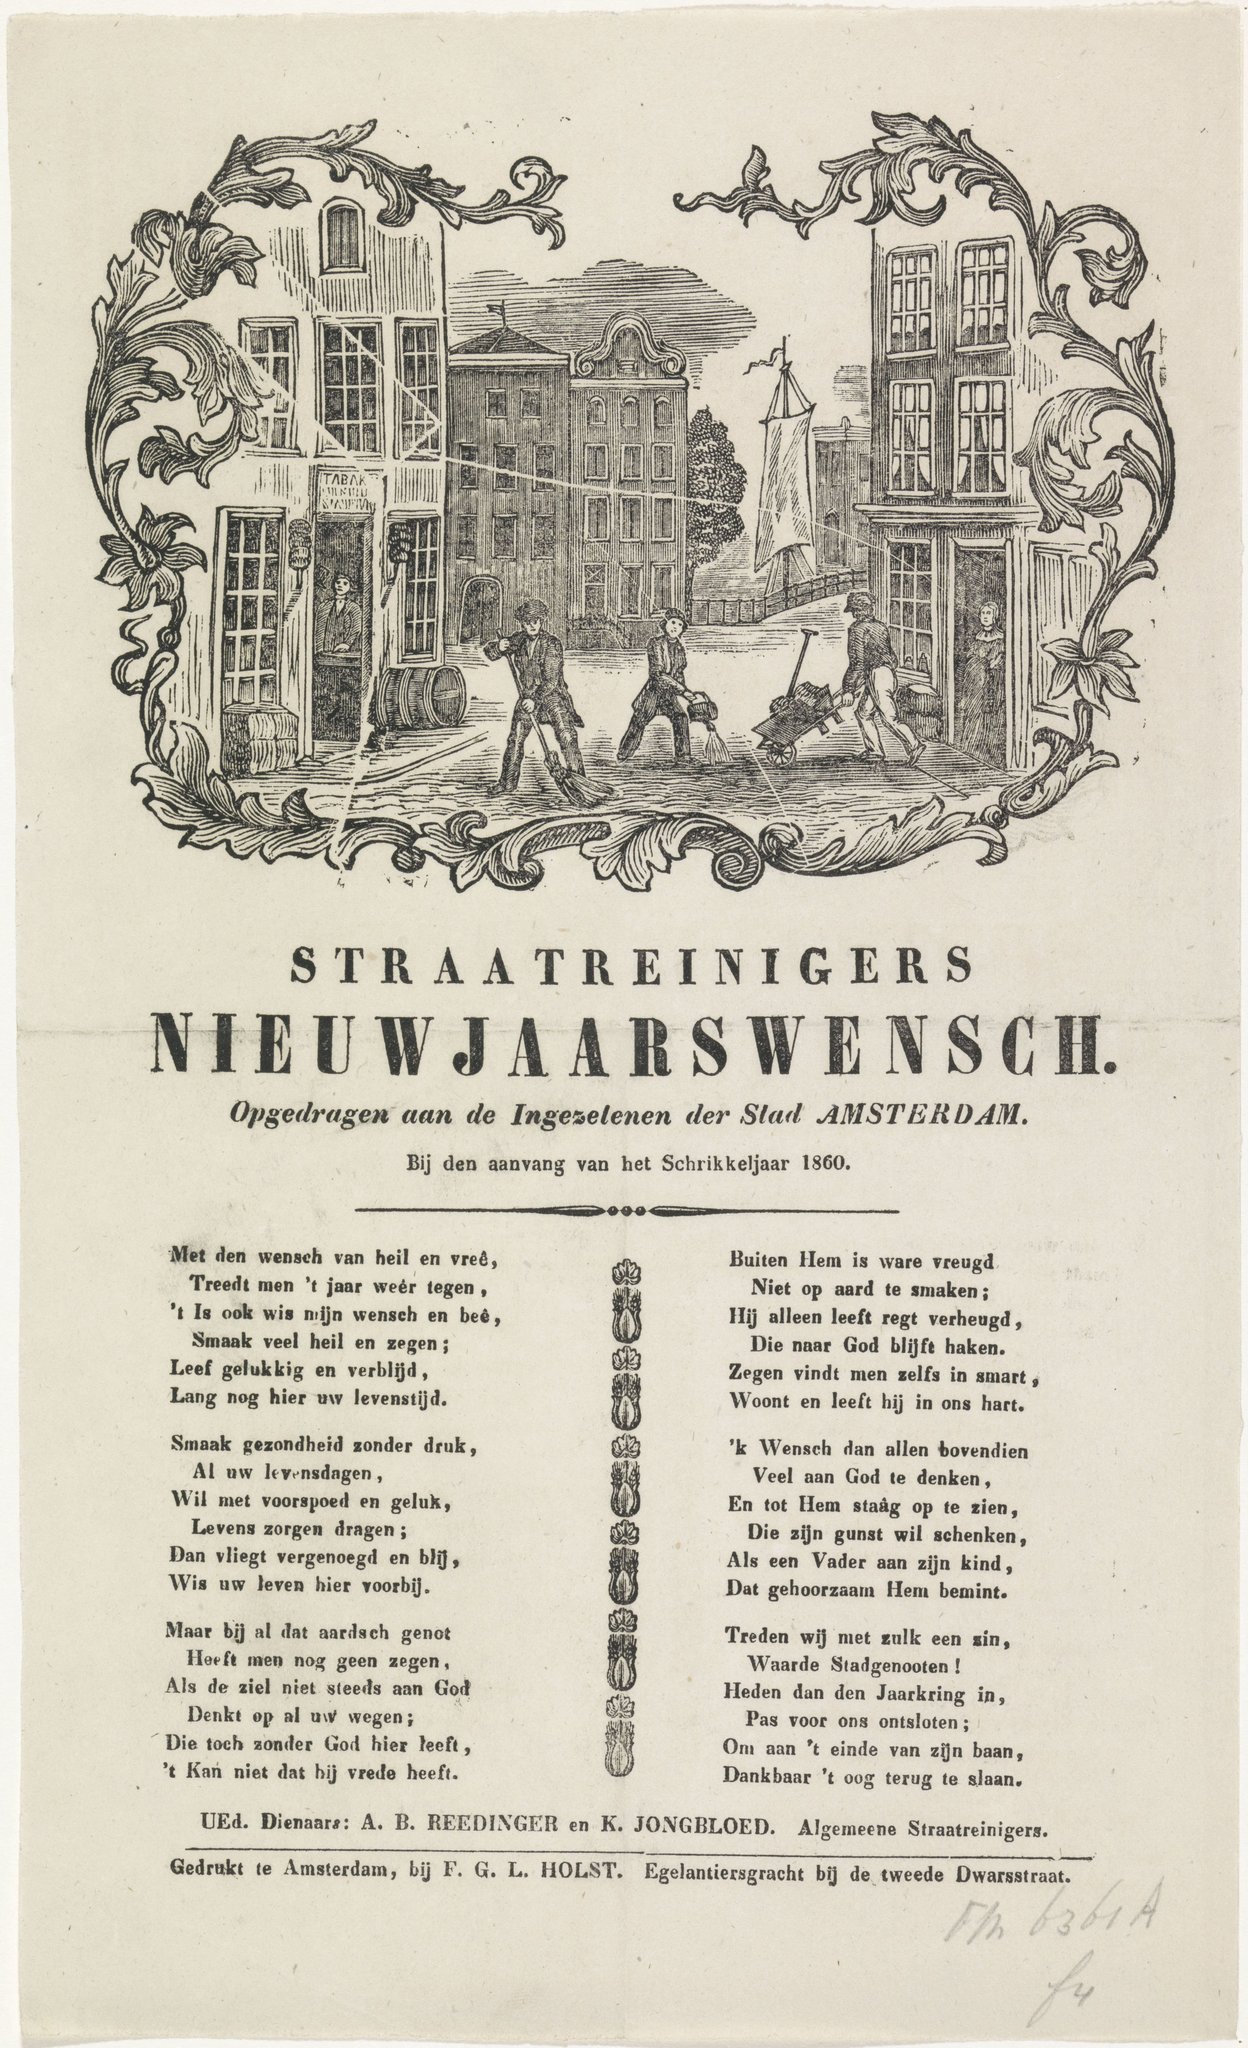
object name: print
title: Straatreinigers Nieuwjaarswensch (...) 1860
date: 1859-1860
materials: paper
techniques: letterpress printing, engraving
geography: amsterdam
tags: street - ii - ideal city, street sweeping, street sweeper, amsterdam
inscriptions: collector's mark: Lugt 2228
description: Nieuwjaarswens van de Amsterdamse straatvegers voor het jaar 1860. Gezicht in een straat te Amsterdam, waar twee straatvegers aan het werk zijn. Met een vers in twee kolommen. Namens de straatvegers: A.B. Reedinger en K. Jongbloed.